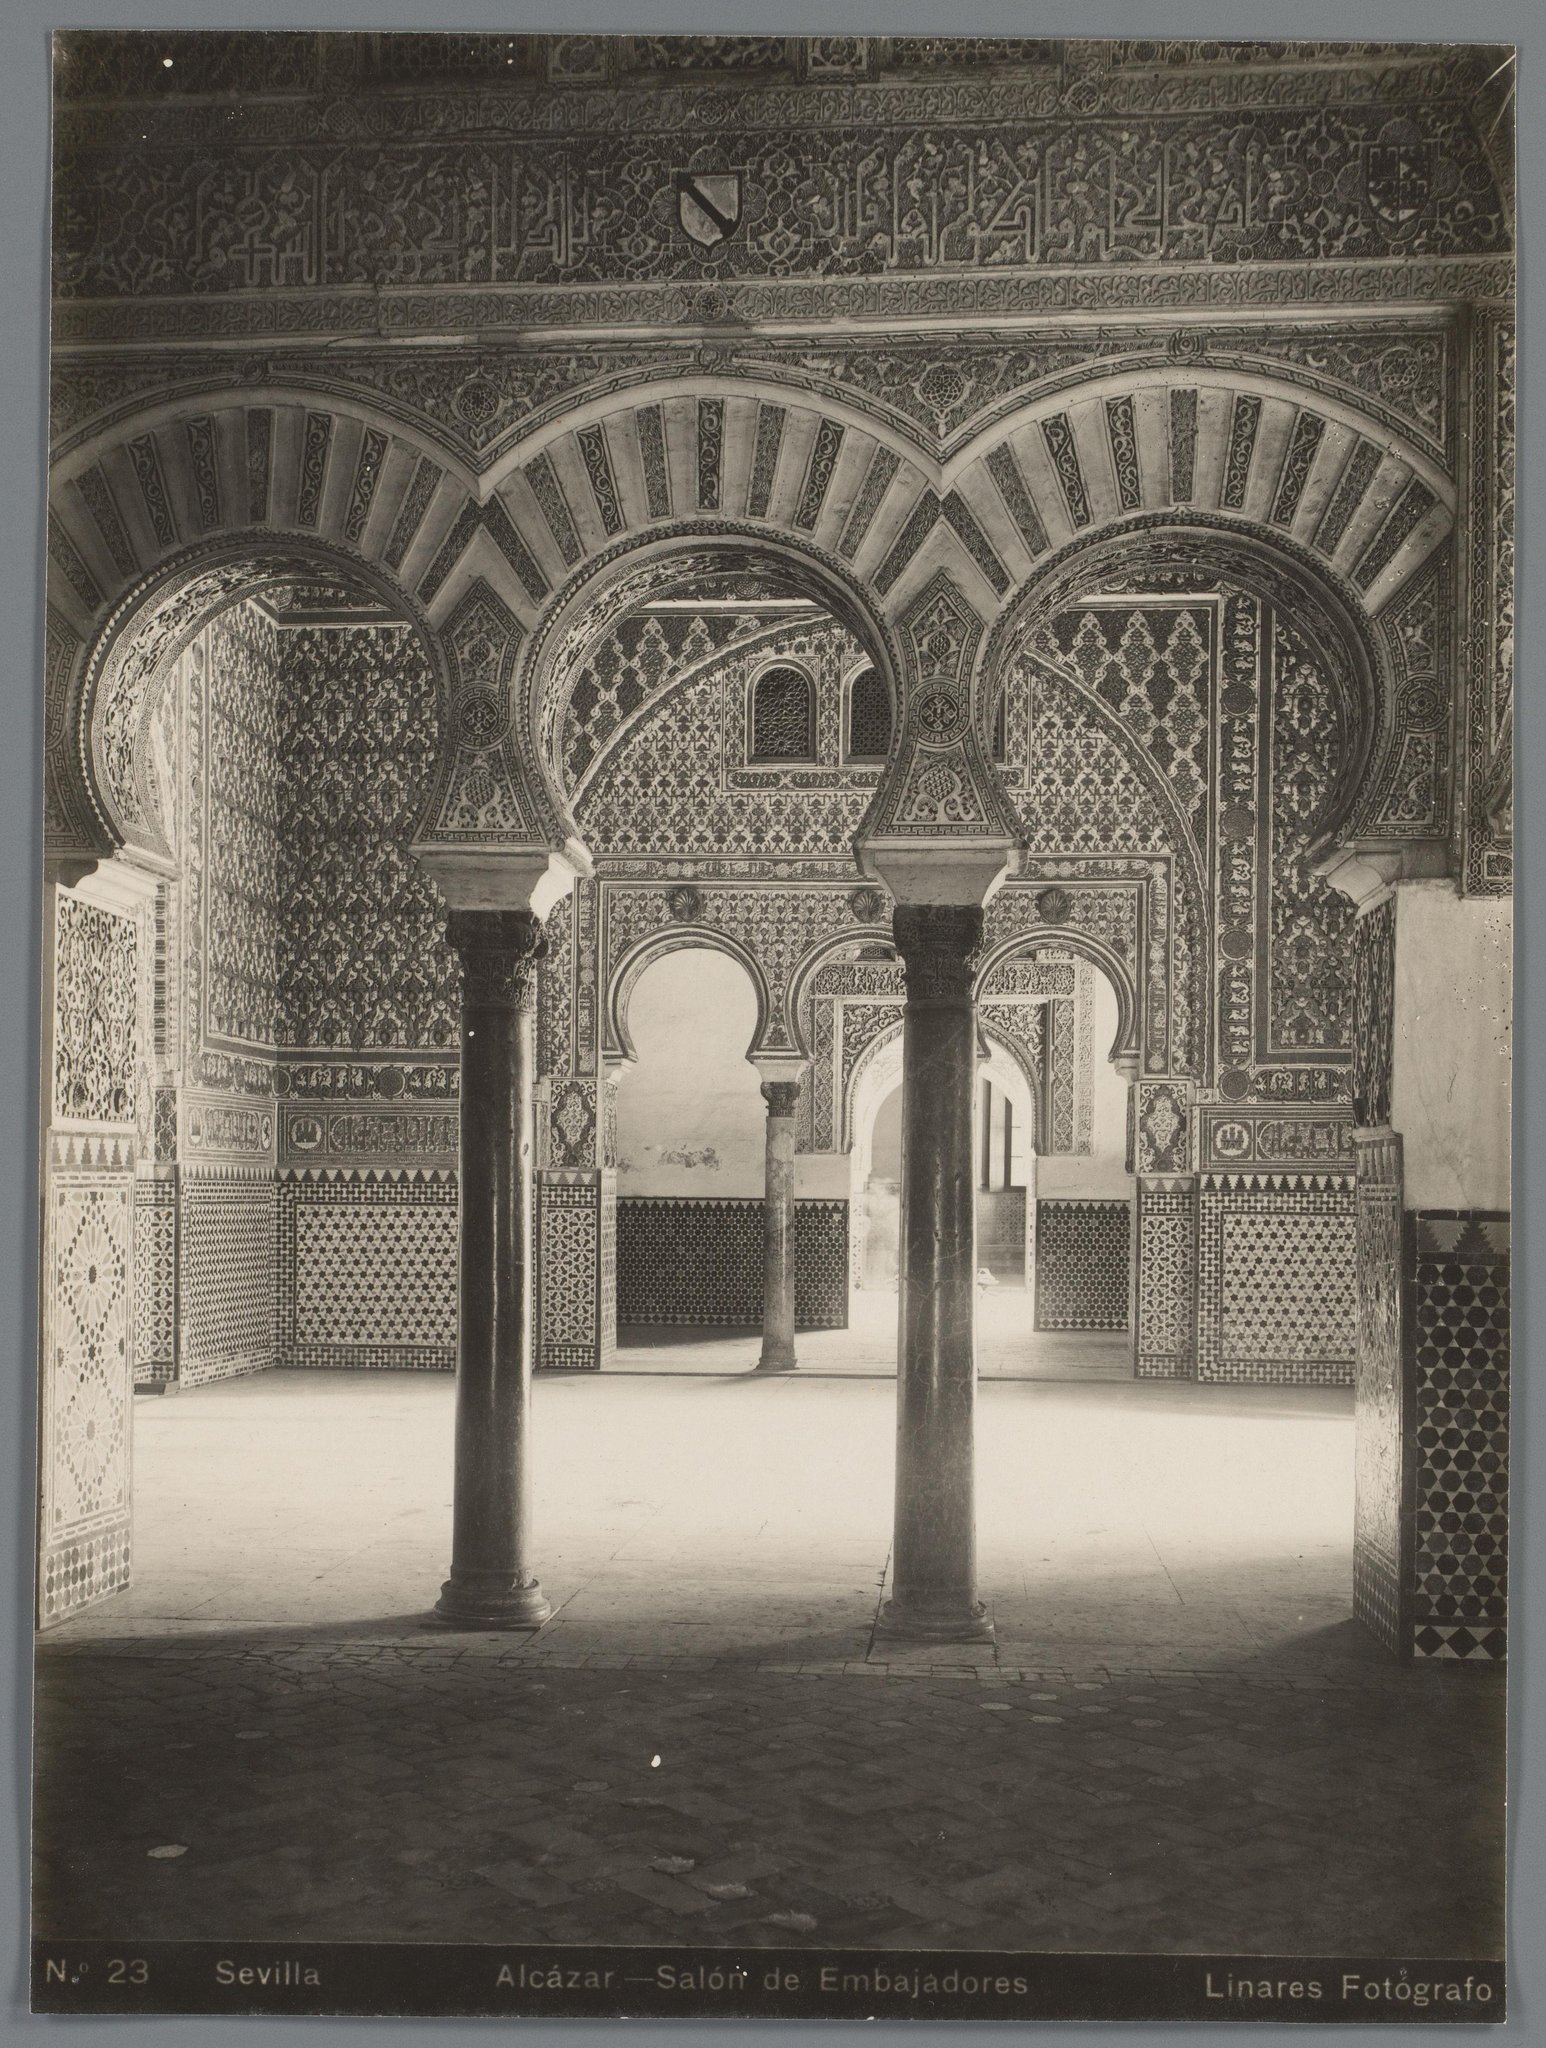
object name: photograph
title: Sevilla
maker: f. linares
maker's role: publisher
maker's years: 1870-1937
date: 1914-1937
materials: photographic support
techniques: gelatin silver print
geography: sevilla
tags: column, pillar ~ architecture, palace, stuccoeing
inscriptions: number: ‘No. 23’